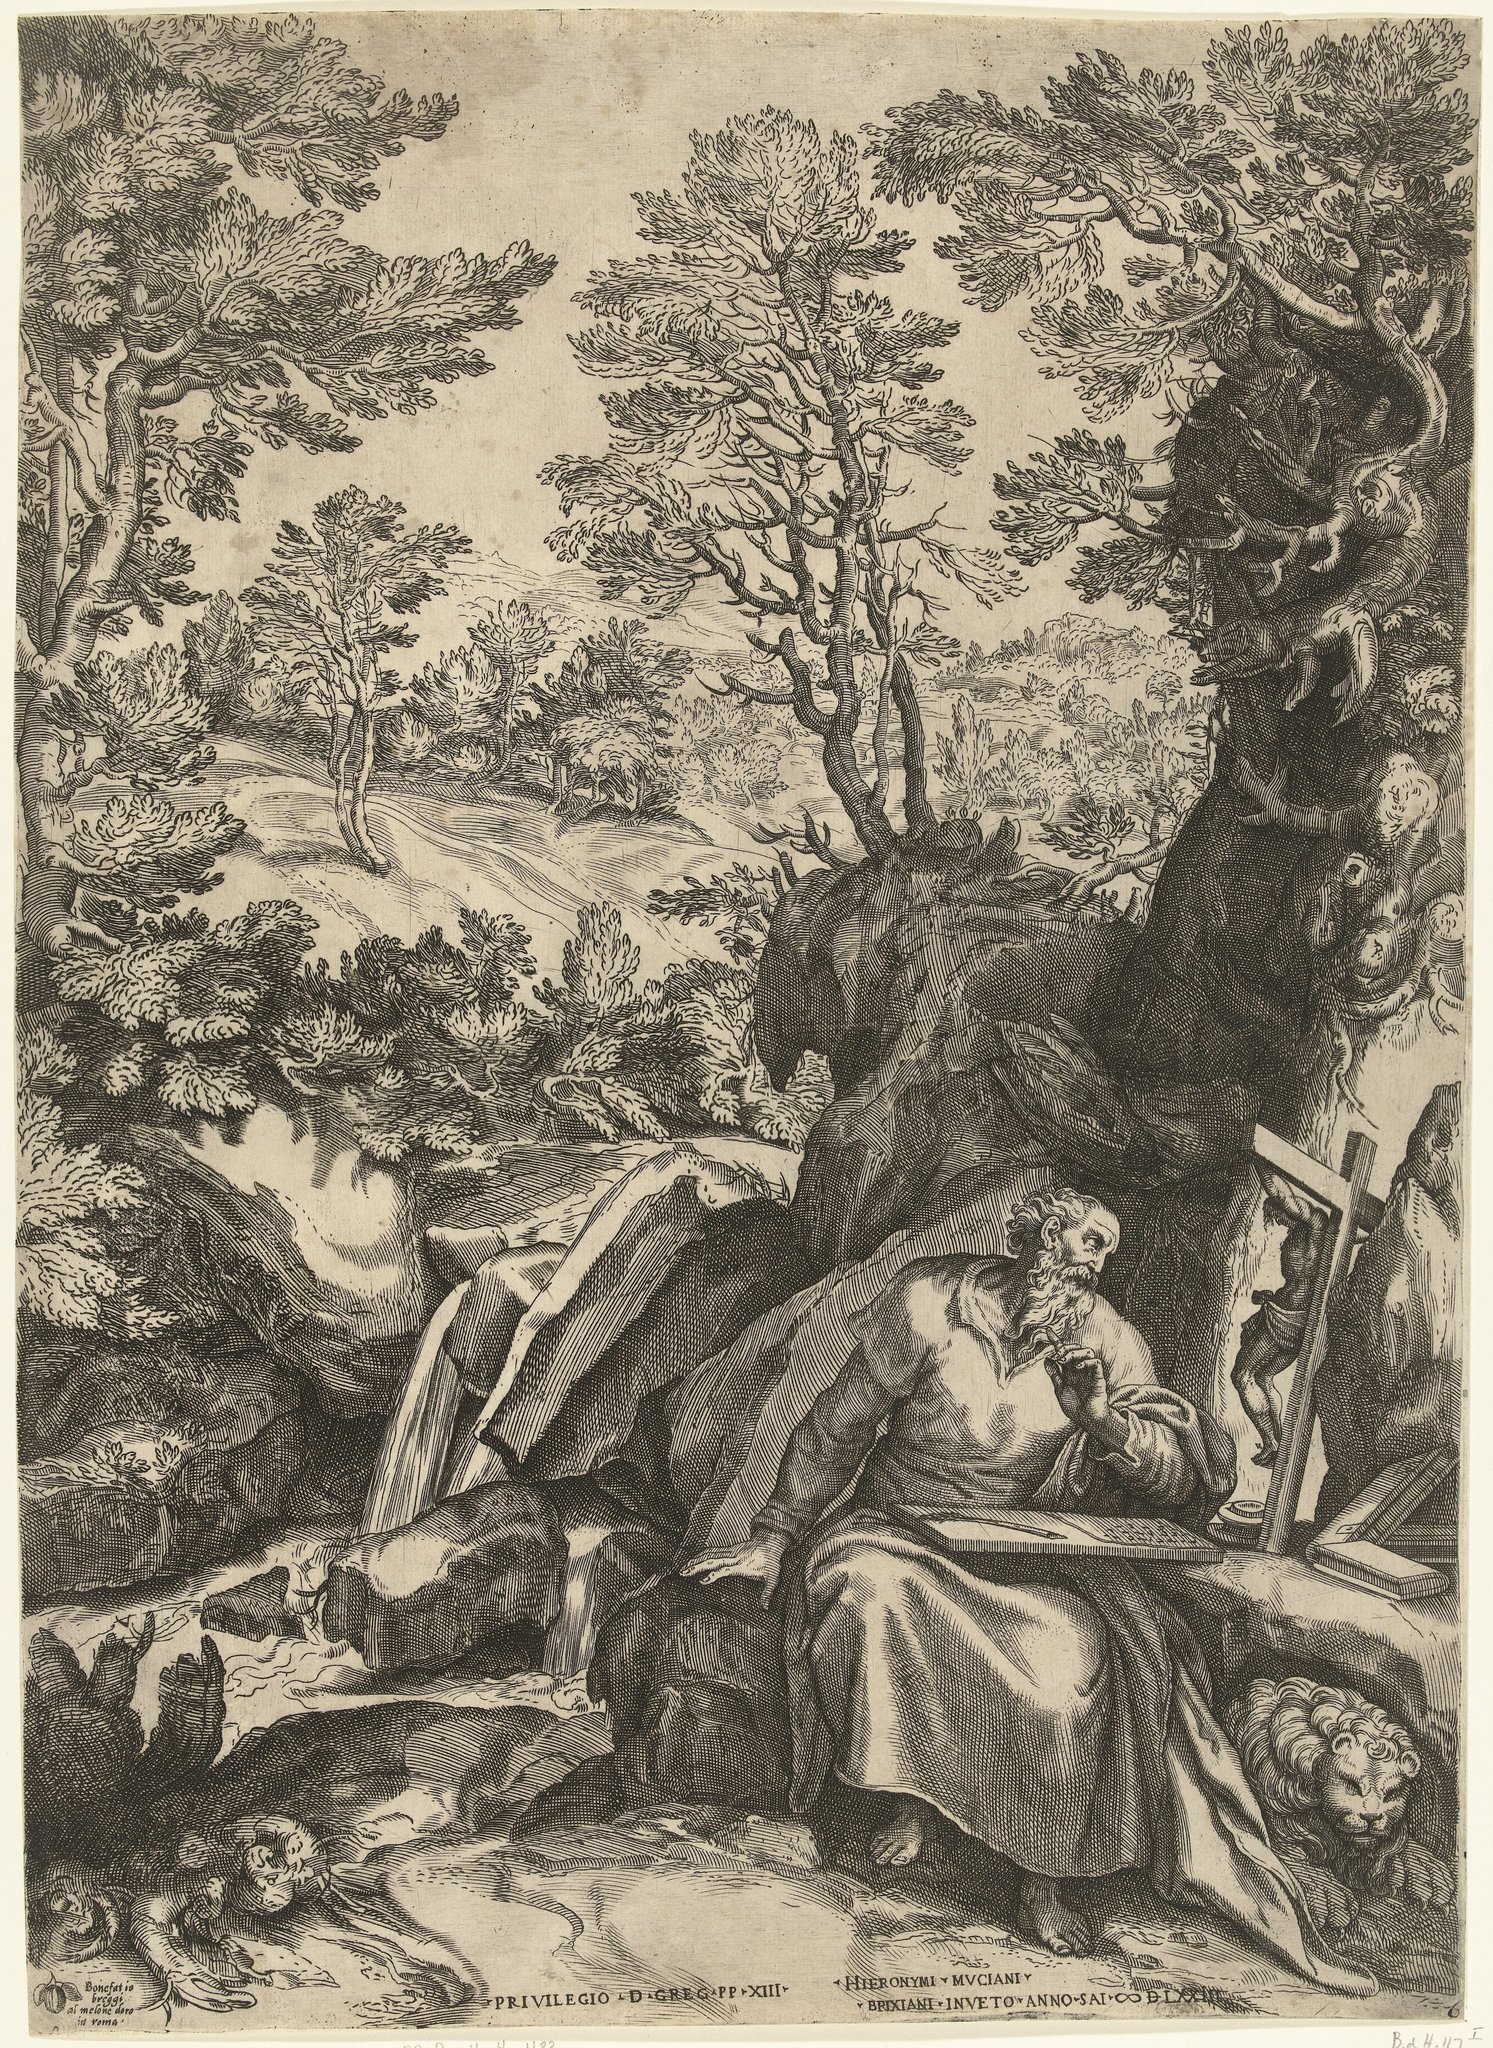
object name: print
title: Landschap met de H. Hieronymus die de bijbel vertaalt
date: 1573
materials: paper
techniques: engraving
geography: rome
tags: st. jerome translating the old and the new testament into latin (the vulgate)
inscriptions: collector's mark: Lugt 11